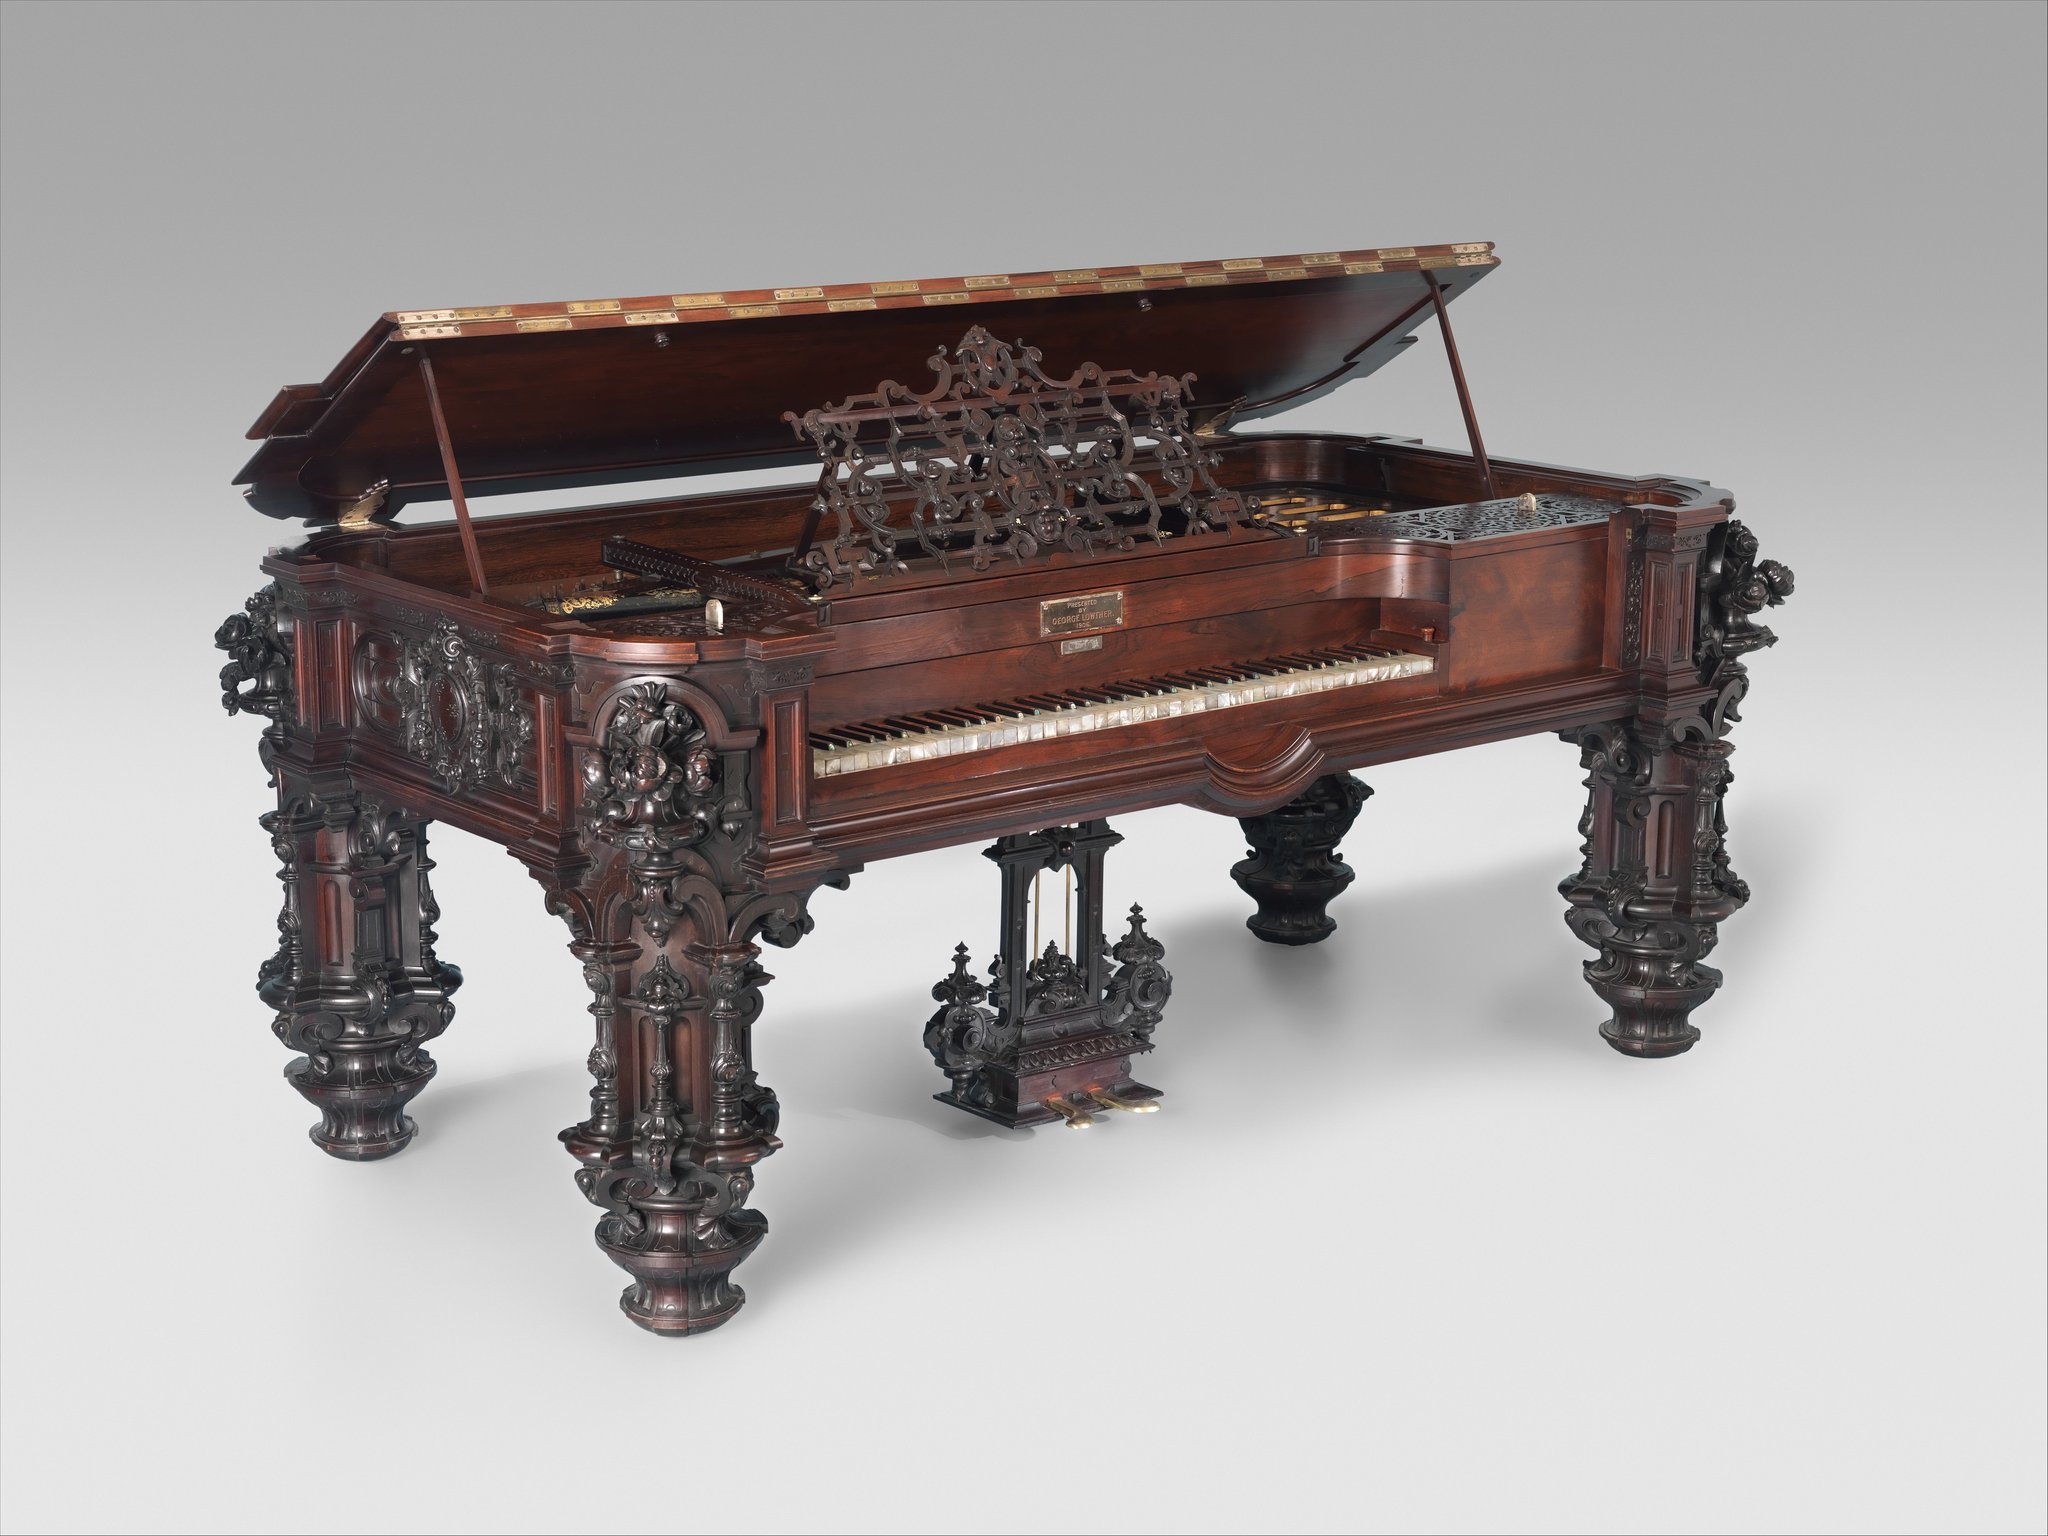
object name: square piano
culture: american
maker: robert nunns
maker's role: maker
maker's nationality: british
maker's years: 1791-1869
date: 1853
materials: felt, metal, mother of pearl, paint, wood, shell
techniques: gilding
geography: united states